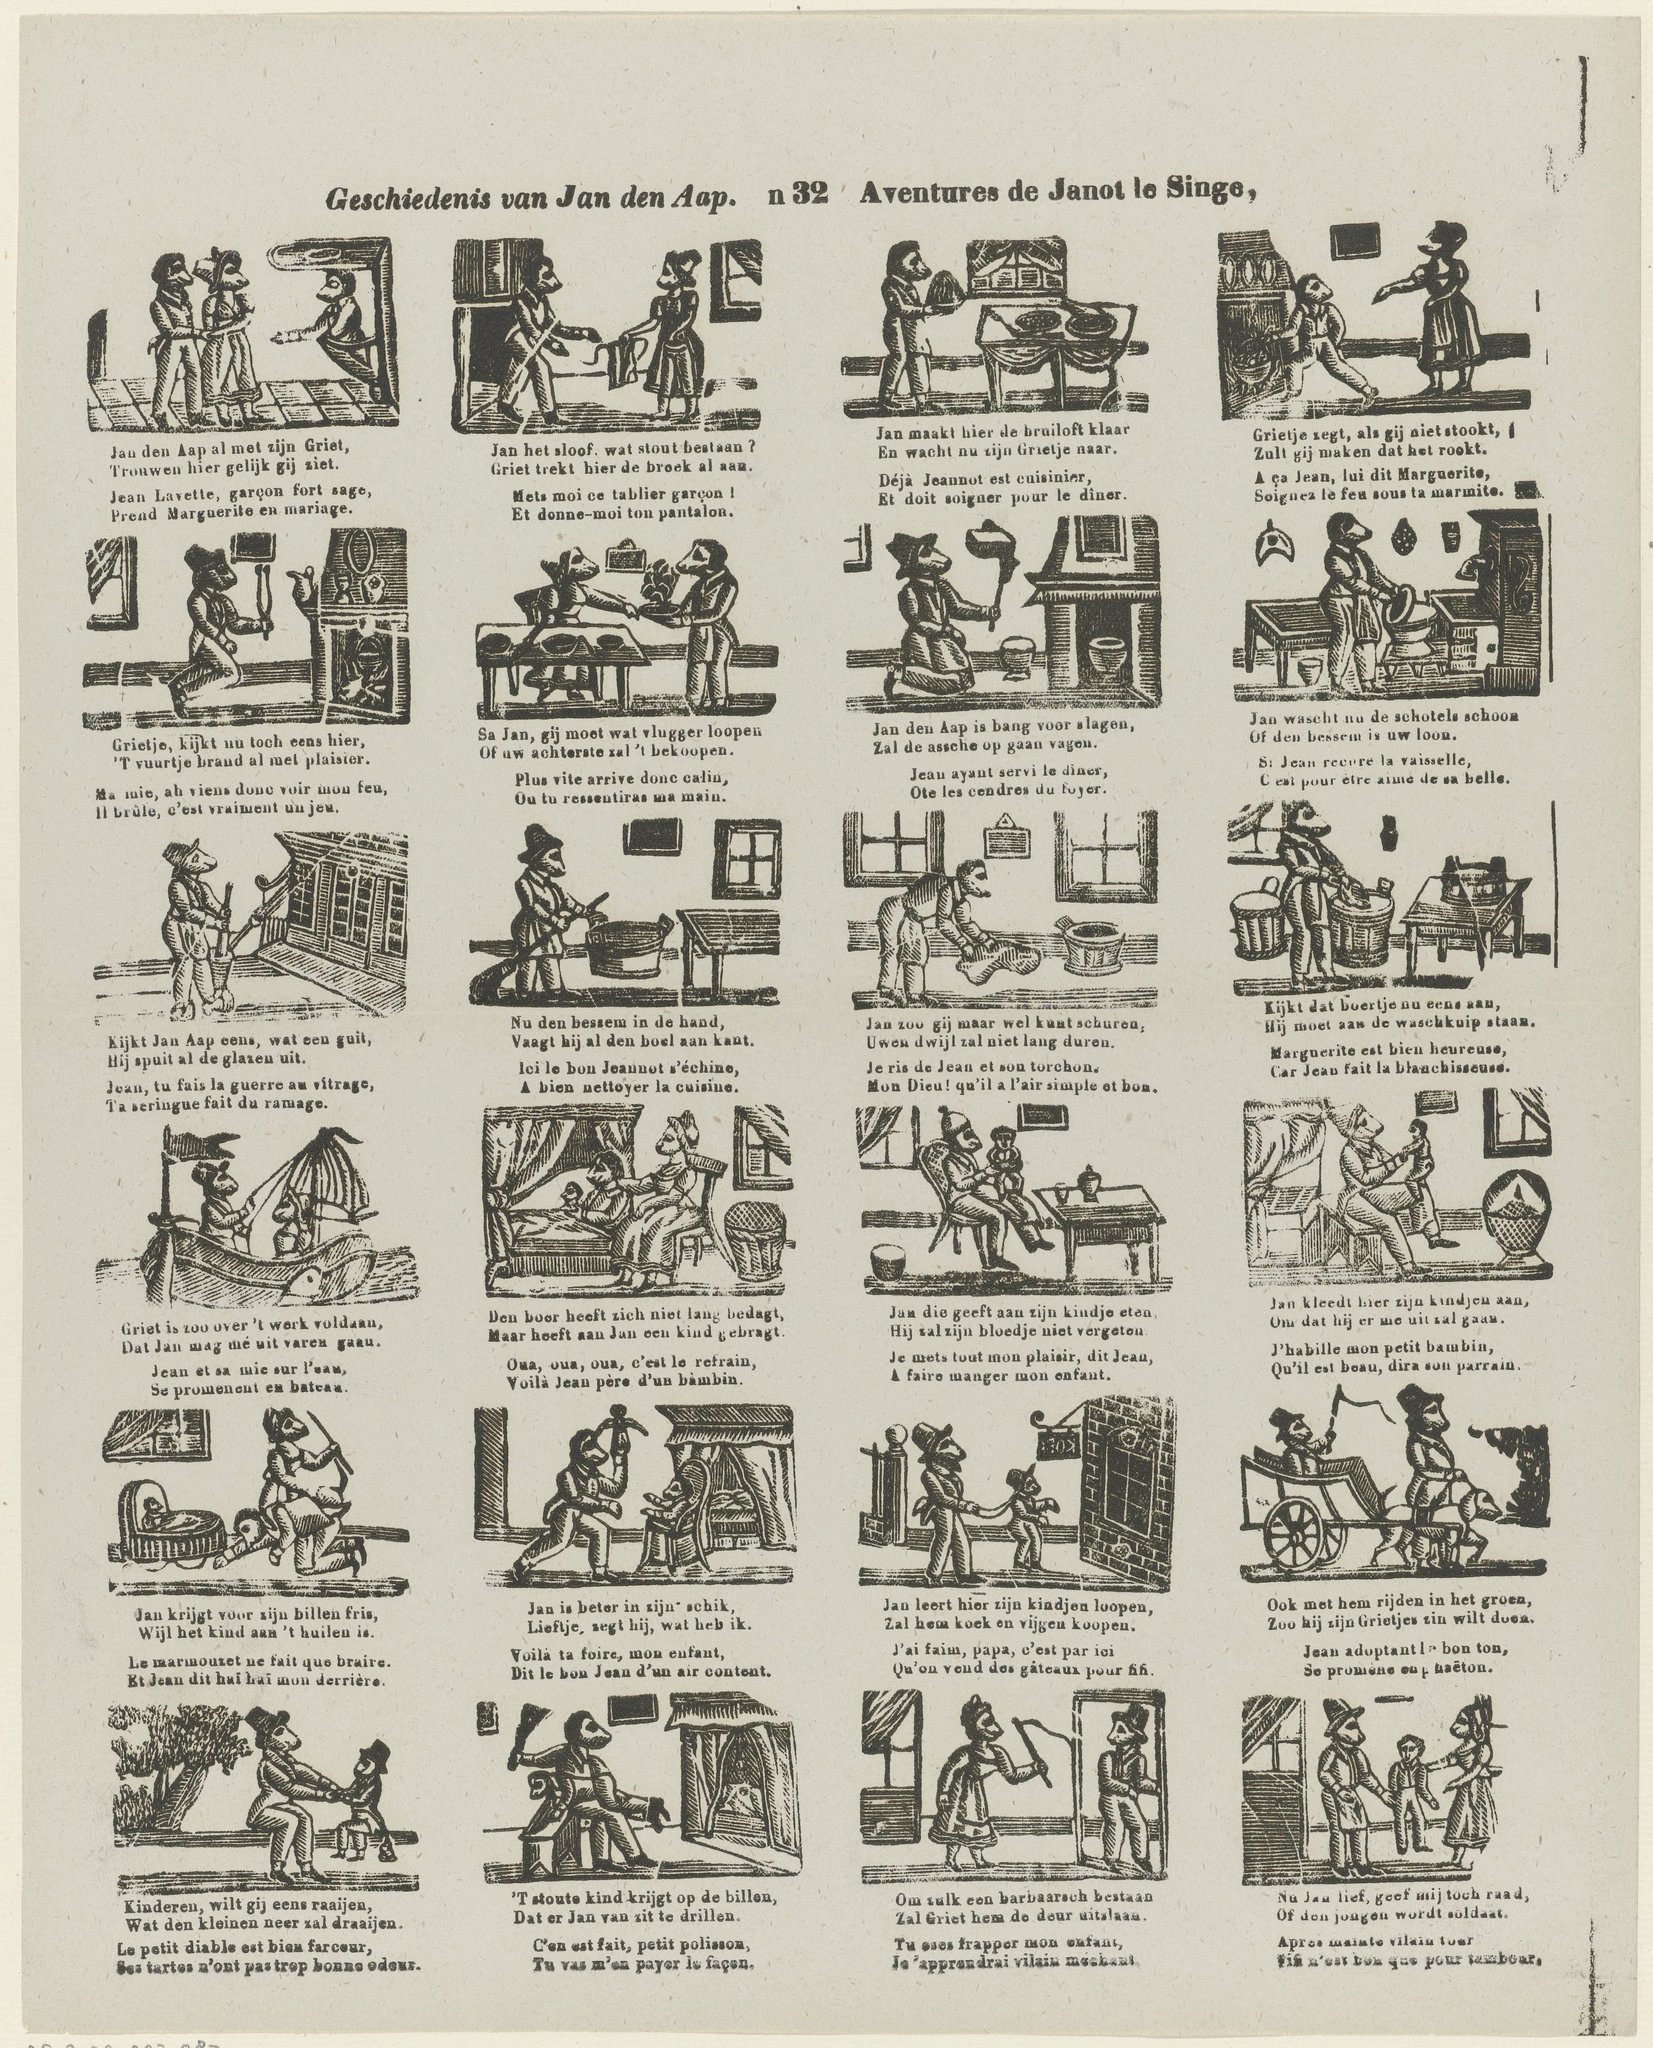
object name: popular print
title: Geschiedenis van Jan den Aap / Aventures de Janot le Singe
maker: Anonymous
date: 1856-1900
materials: paper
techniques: letterpress printing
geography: turnhout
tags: hen-pecked husband, 'betty', 'molly' (man who engages in women's work), monkeys, apes, animals acting as human beings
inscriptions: collector's mark: Lugt 2760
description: Blad met 24 voorstellingen uit het leven van Jan de Wasser, een man die van zijn vrouw Griet, die de broek aan heeft, al het huishoudelijk werk moet doen. Uitgebeeld met apen in plaats van mensen. Onder elke voorstelling een tweeregelig vers in het Nederlands en in het Frans. Genummerd midden boven: n 32.